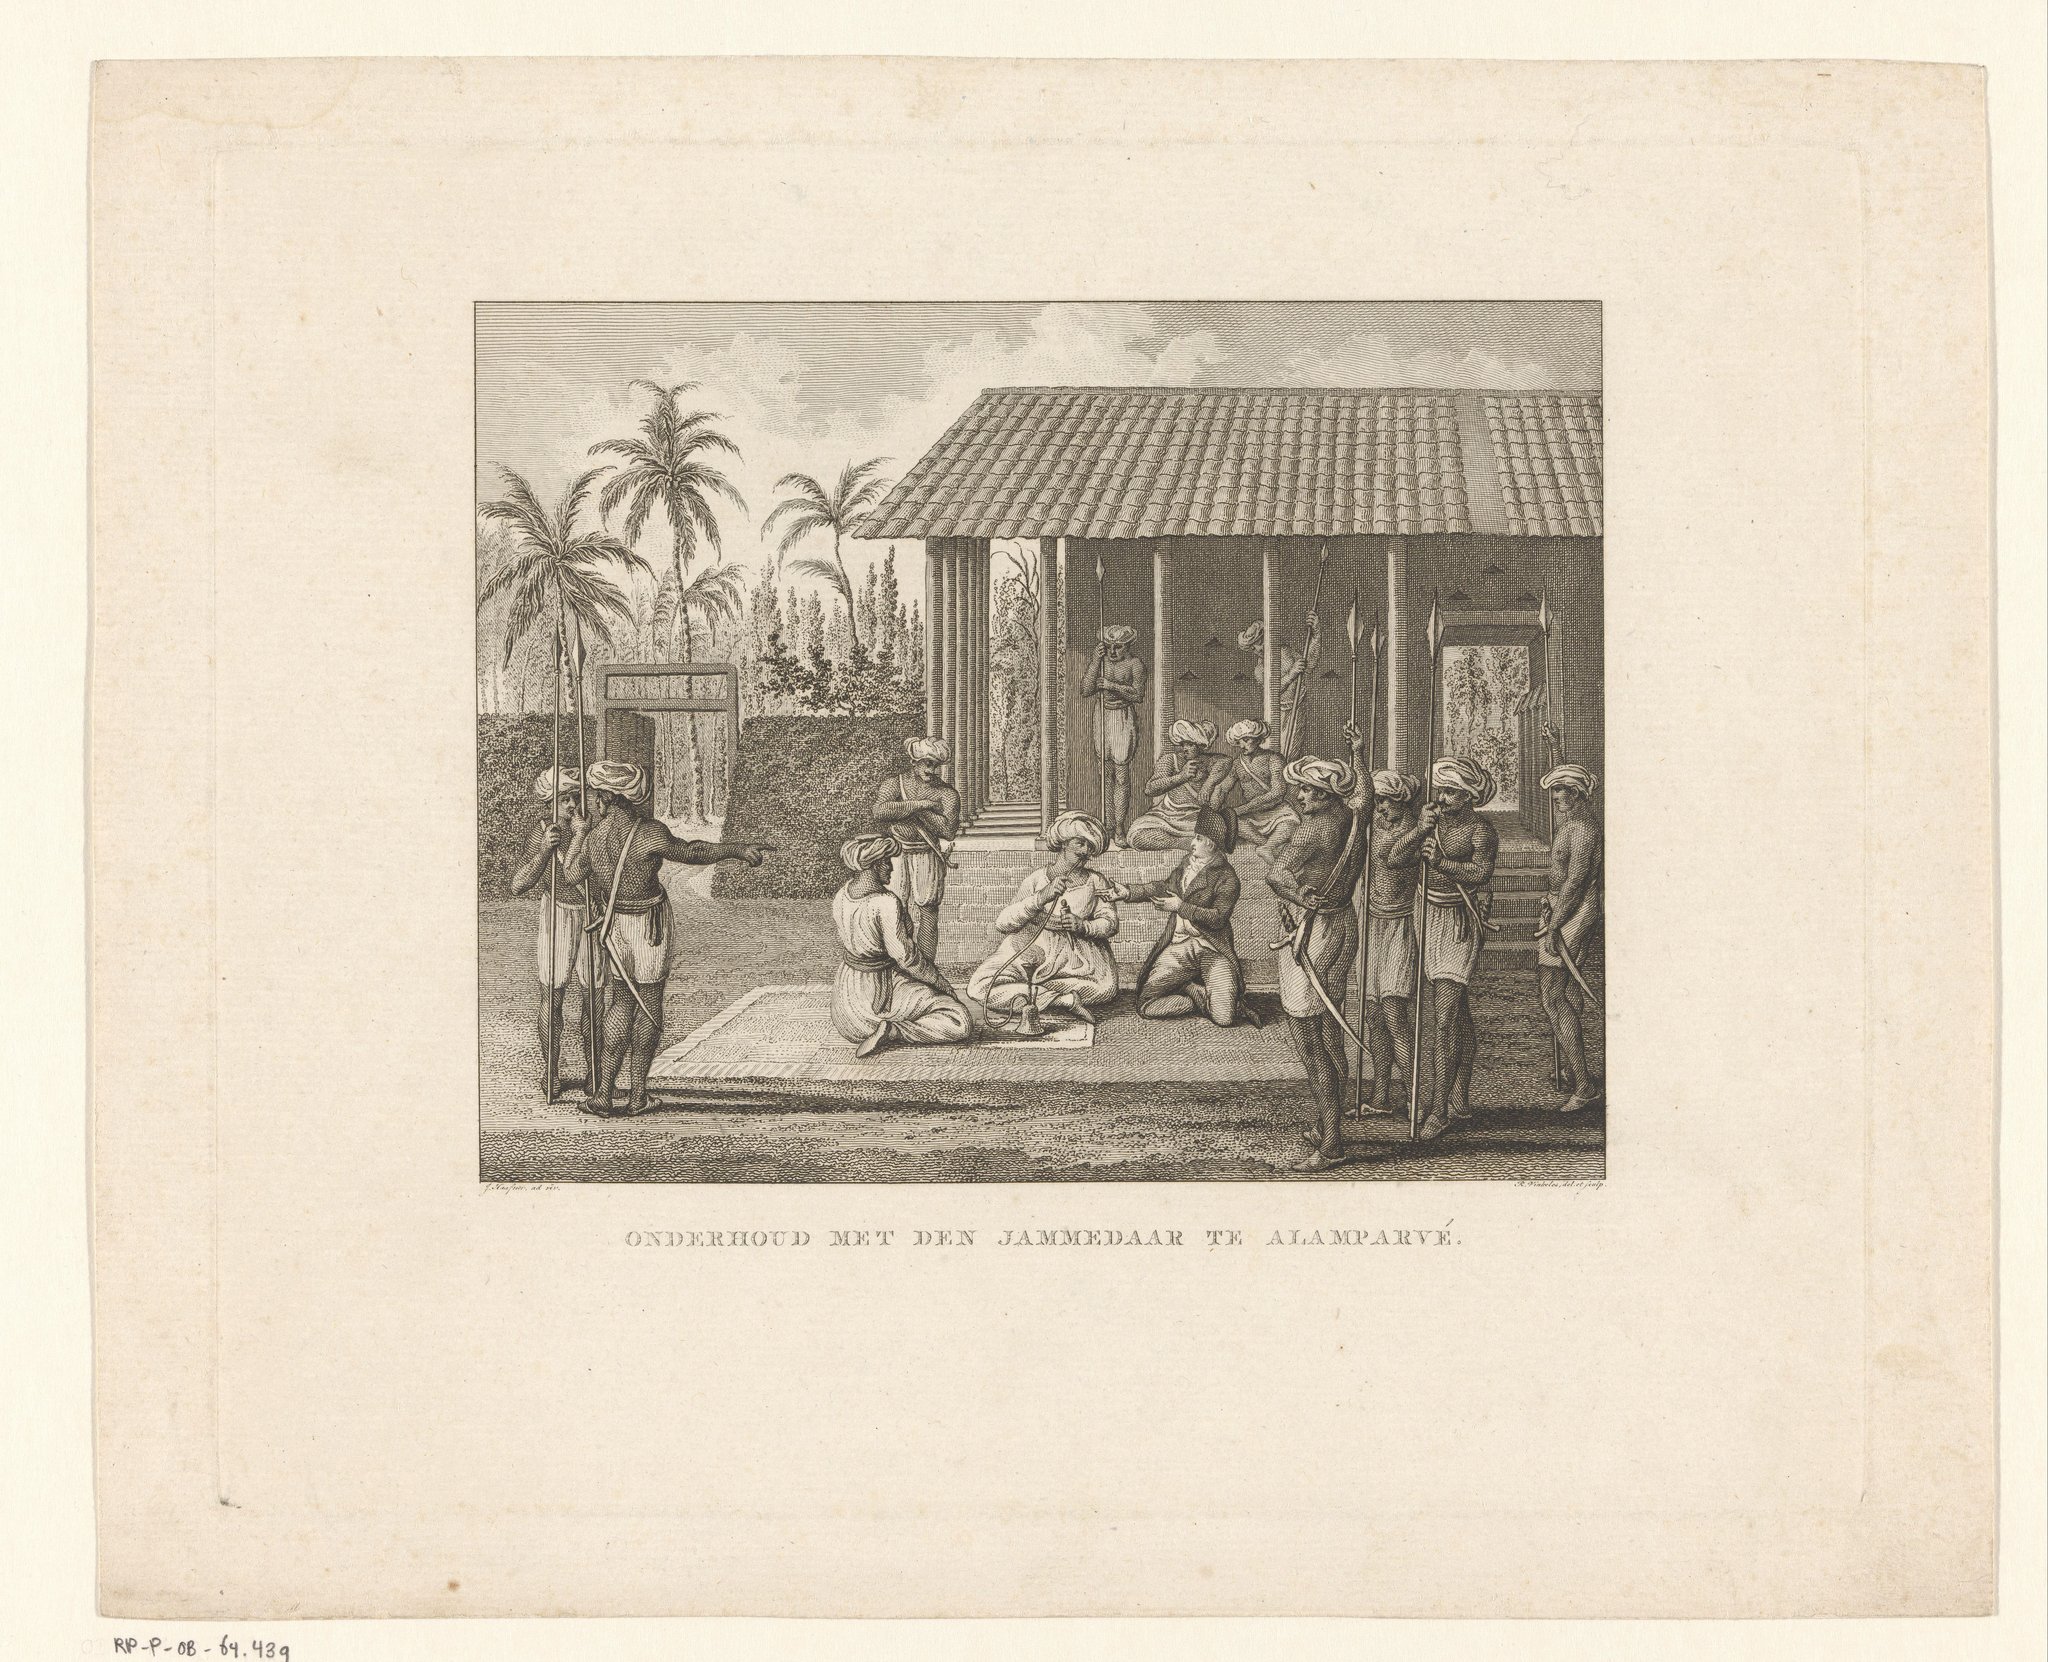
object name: print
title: Jacob Haafner op Ceylon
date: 1806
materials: paper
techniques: engraving, etching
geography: amsterdam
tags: traveler, jacob godfried haafner, water-pipe, hookah, narghile, asiatic races and peoples, casting weapons: spear, head-gear: turban, negotiations, conference ~ diplomacy, sri lanka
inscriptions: collector's mark: Lugt 2228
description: Jacob Haafner in onderhandeling met een Jammedaar in Alamparvé op Ceylon. De vorst rookt een waterpijp. De mannen zitten op een kleed op de grond voor een gebouw met een zuilengalerij en zijn omringd door staande mannen met speren in hun hand en met tulbanden op.